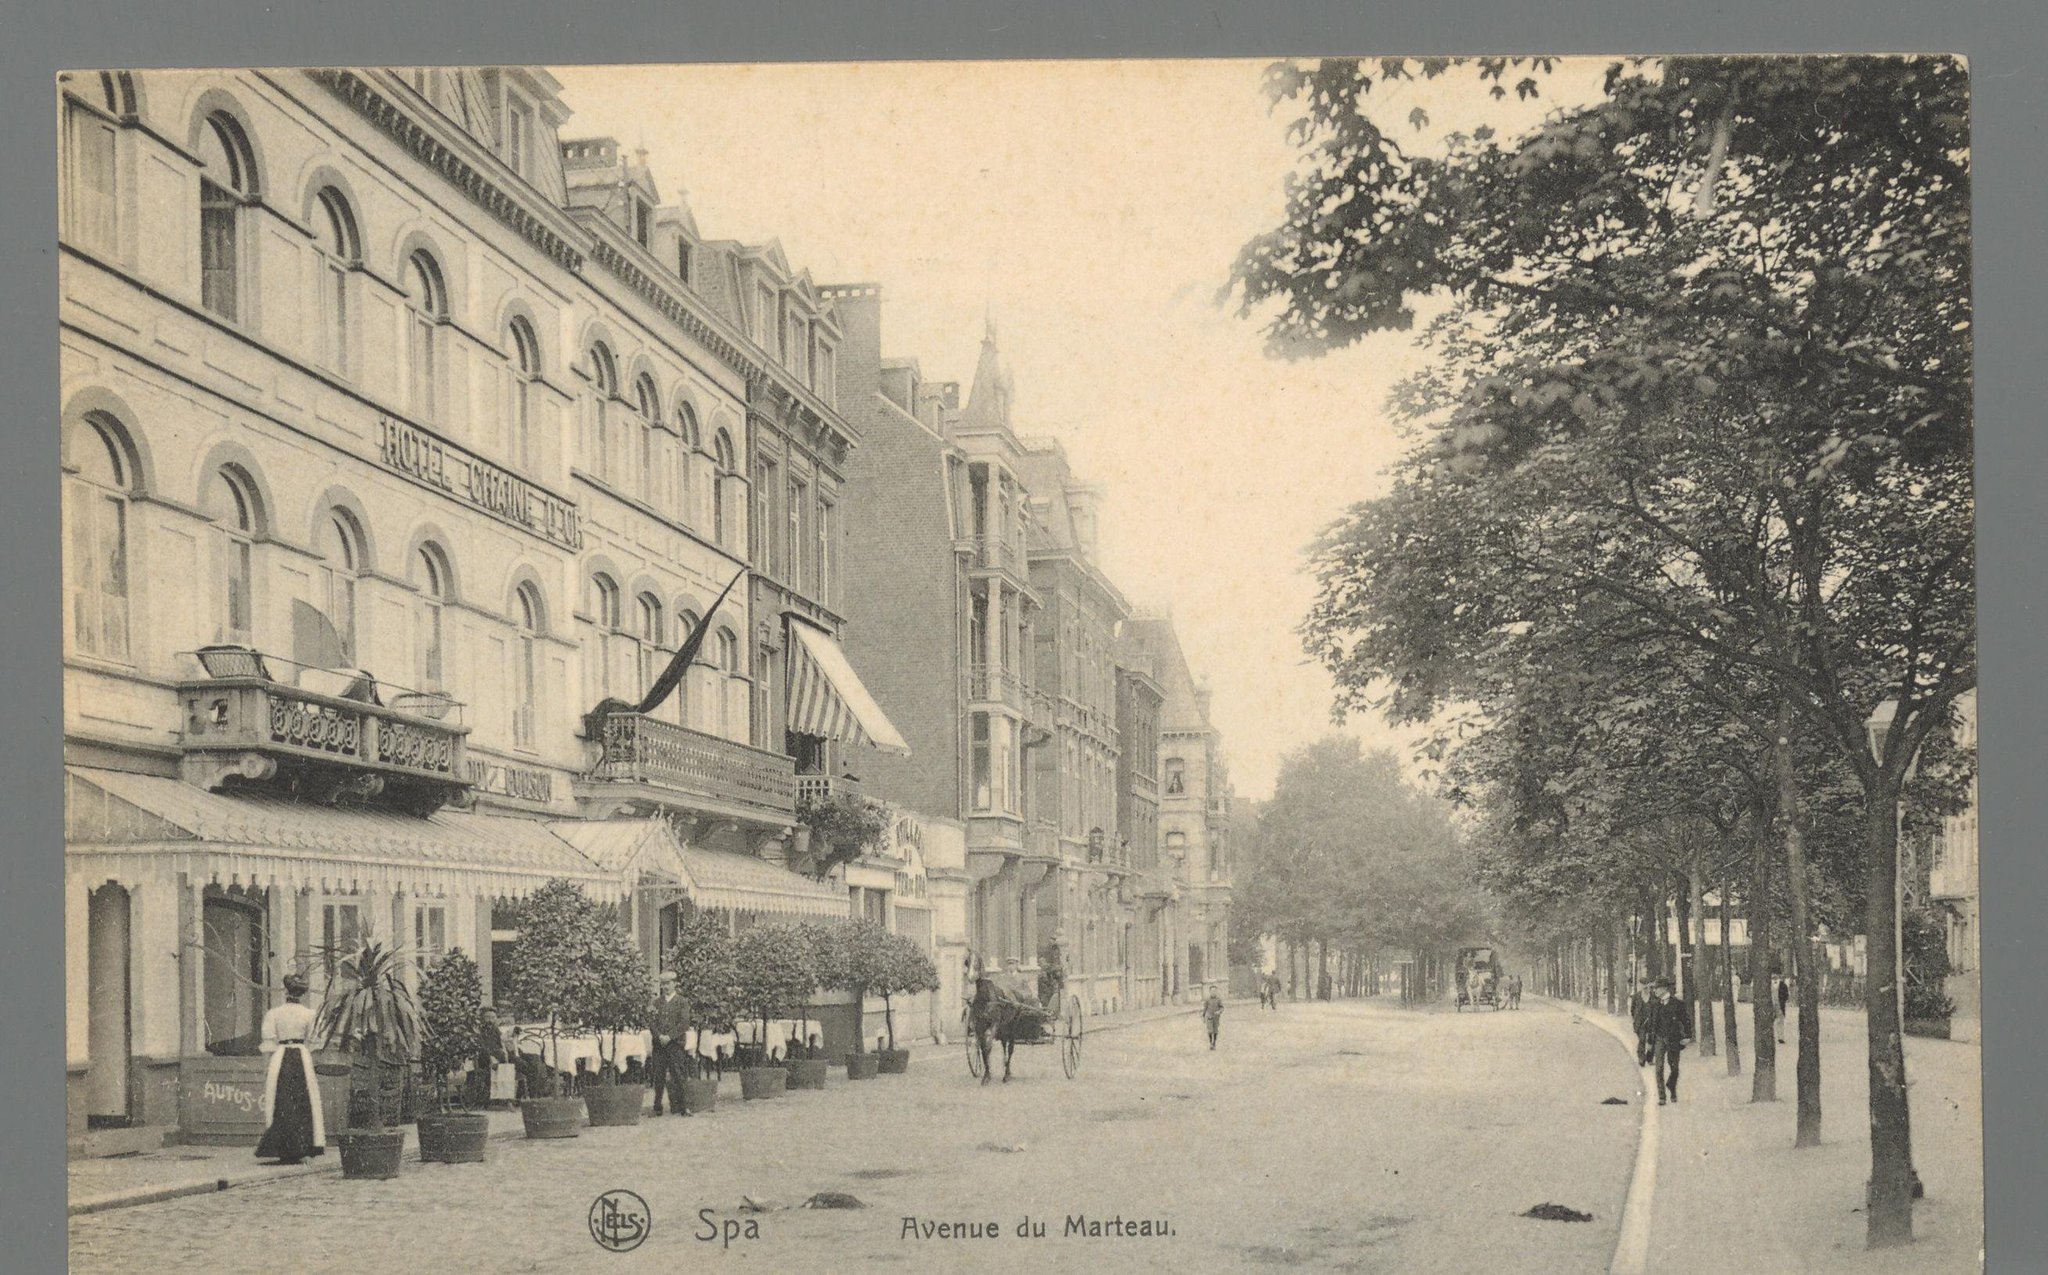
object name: ansichtkaart, prentbriefkaart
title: Spa. Avenue du Marteau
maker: Anonymous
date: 1907-1908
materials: cardboard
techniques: photograph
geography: spa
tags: street, hotel, hostelry, inn